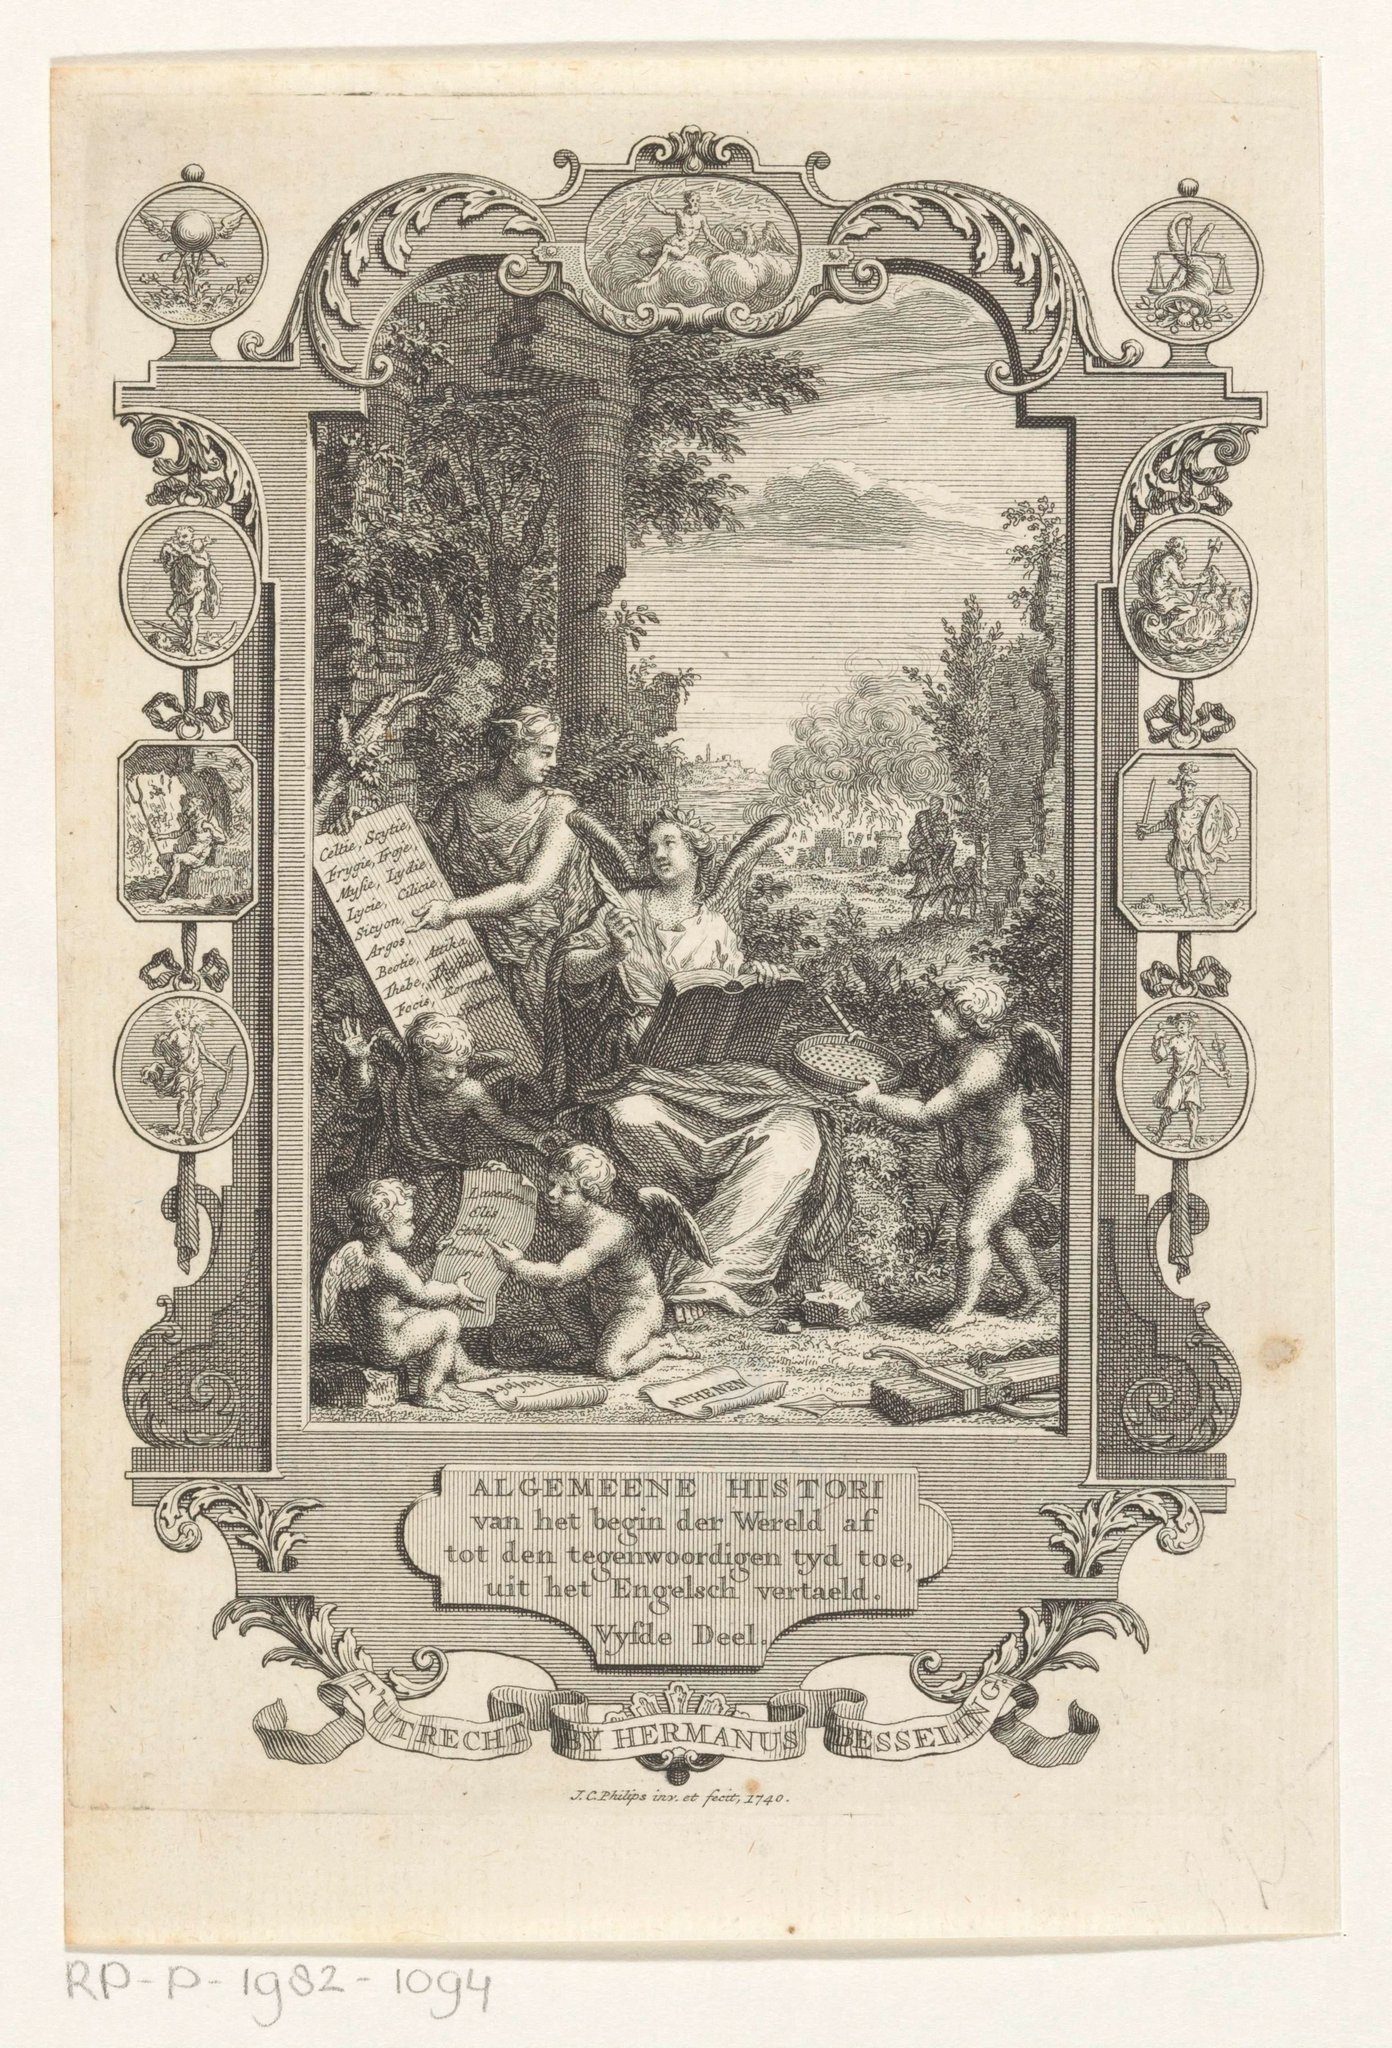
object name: titelblad, titelpagina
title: Cartouche met allegorie op de geschiedenis van de Grieken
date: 1740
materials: paper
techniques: engraving, etching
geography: utrecht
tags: the olympian gods together: jupiter, juno, neptune, ceres, apollo, diana, mars, venus, mercury, minerva, vulcan, vesta (or bacchus), 'pius aeneas': aeneas, leading ascanius, escapes from burning troy, carrying his father anchises with the penates; his wife creusa, who sets out with them, is lost on the way, 'historia'; 'historia' (ripa), the greek heroic legends (i)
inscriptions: collector's mark: Lugt 2760, collector's mark: Lugt 2228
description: Geschiedenis in gesprek met een vrouw, die wijst op een vel papier waarop allerlei Griekse steden. Op de achtergrond Aeneas die zijn vader Anchises redt uit het brandende Troje. In de omlijsting van de cartouche medaillons met goden van de Olympus.